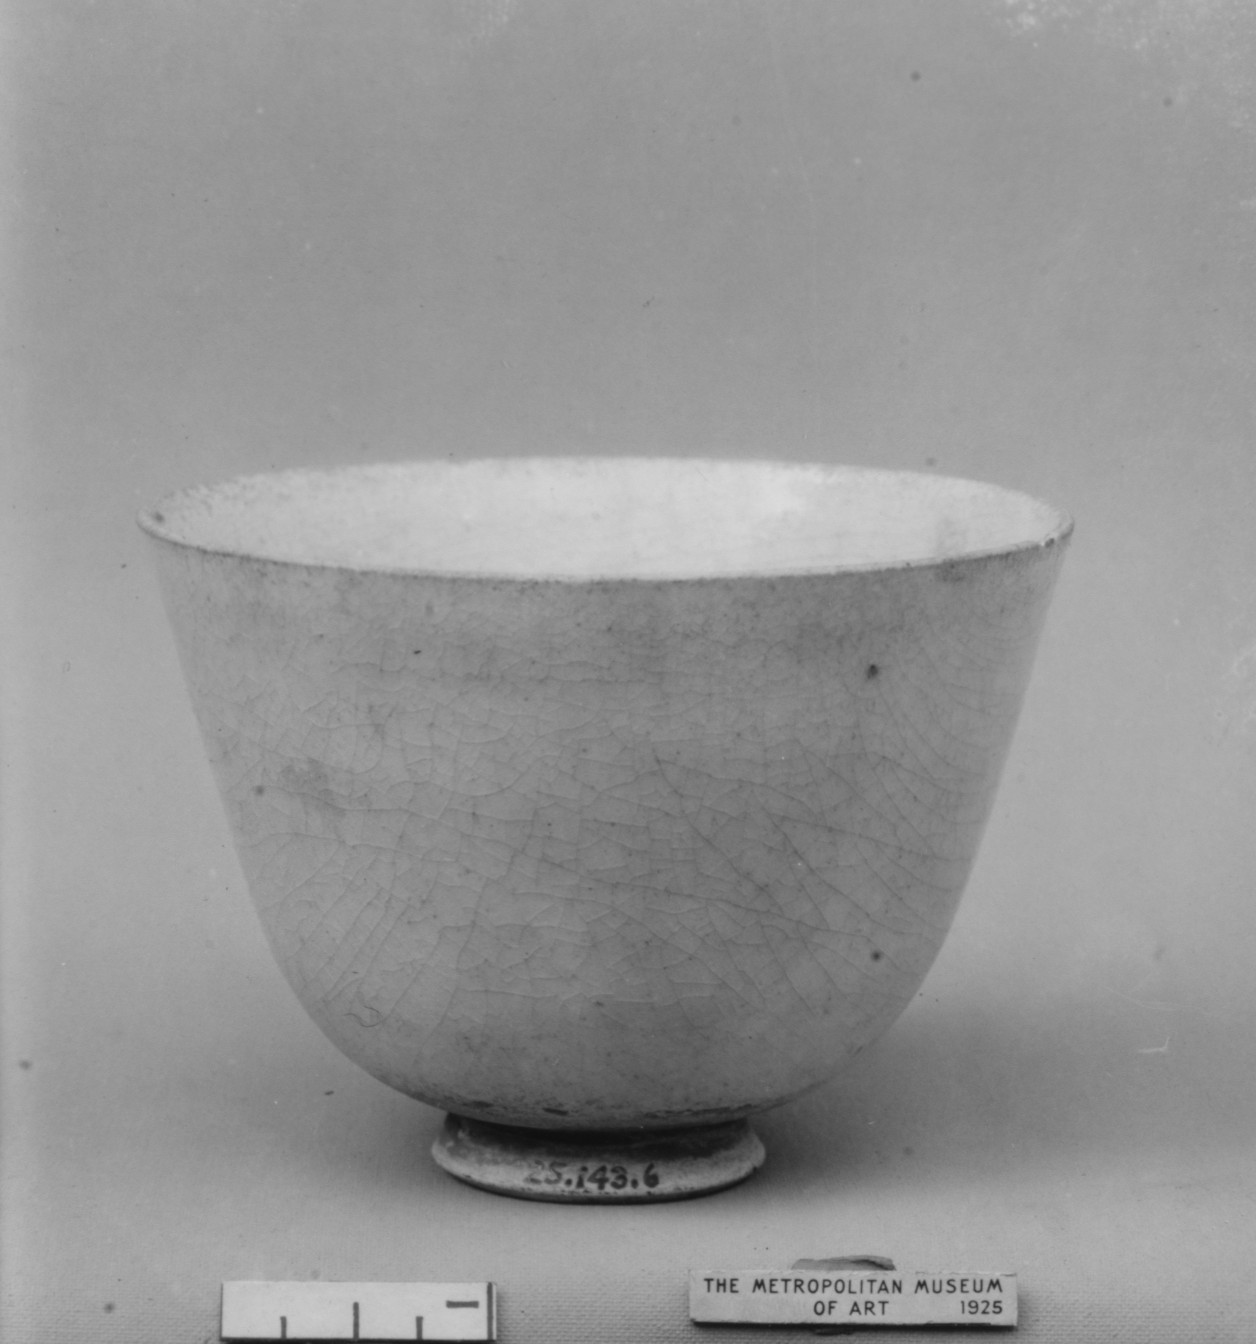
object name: cup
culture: chinese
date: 618-907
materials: glaze, stoneware